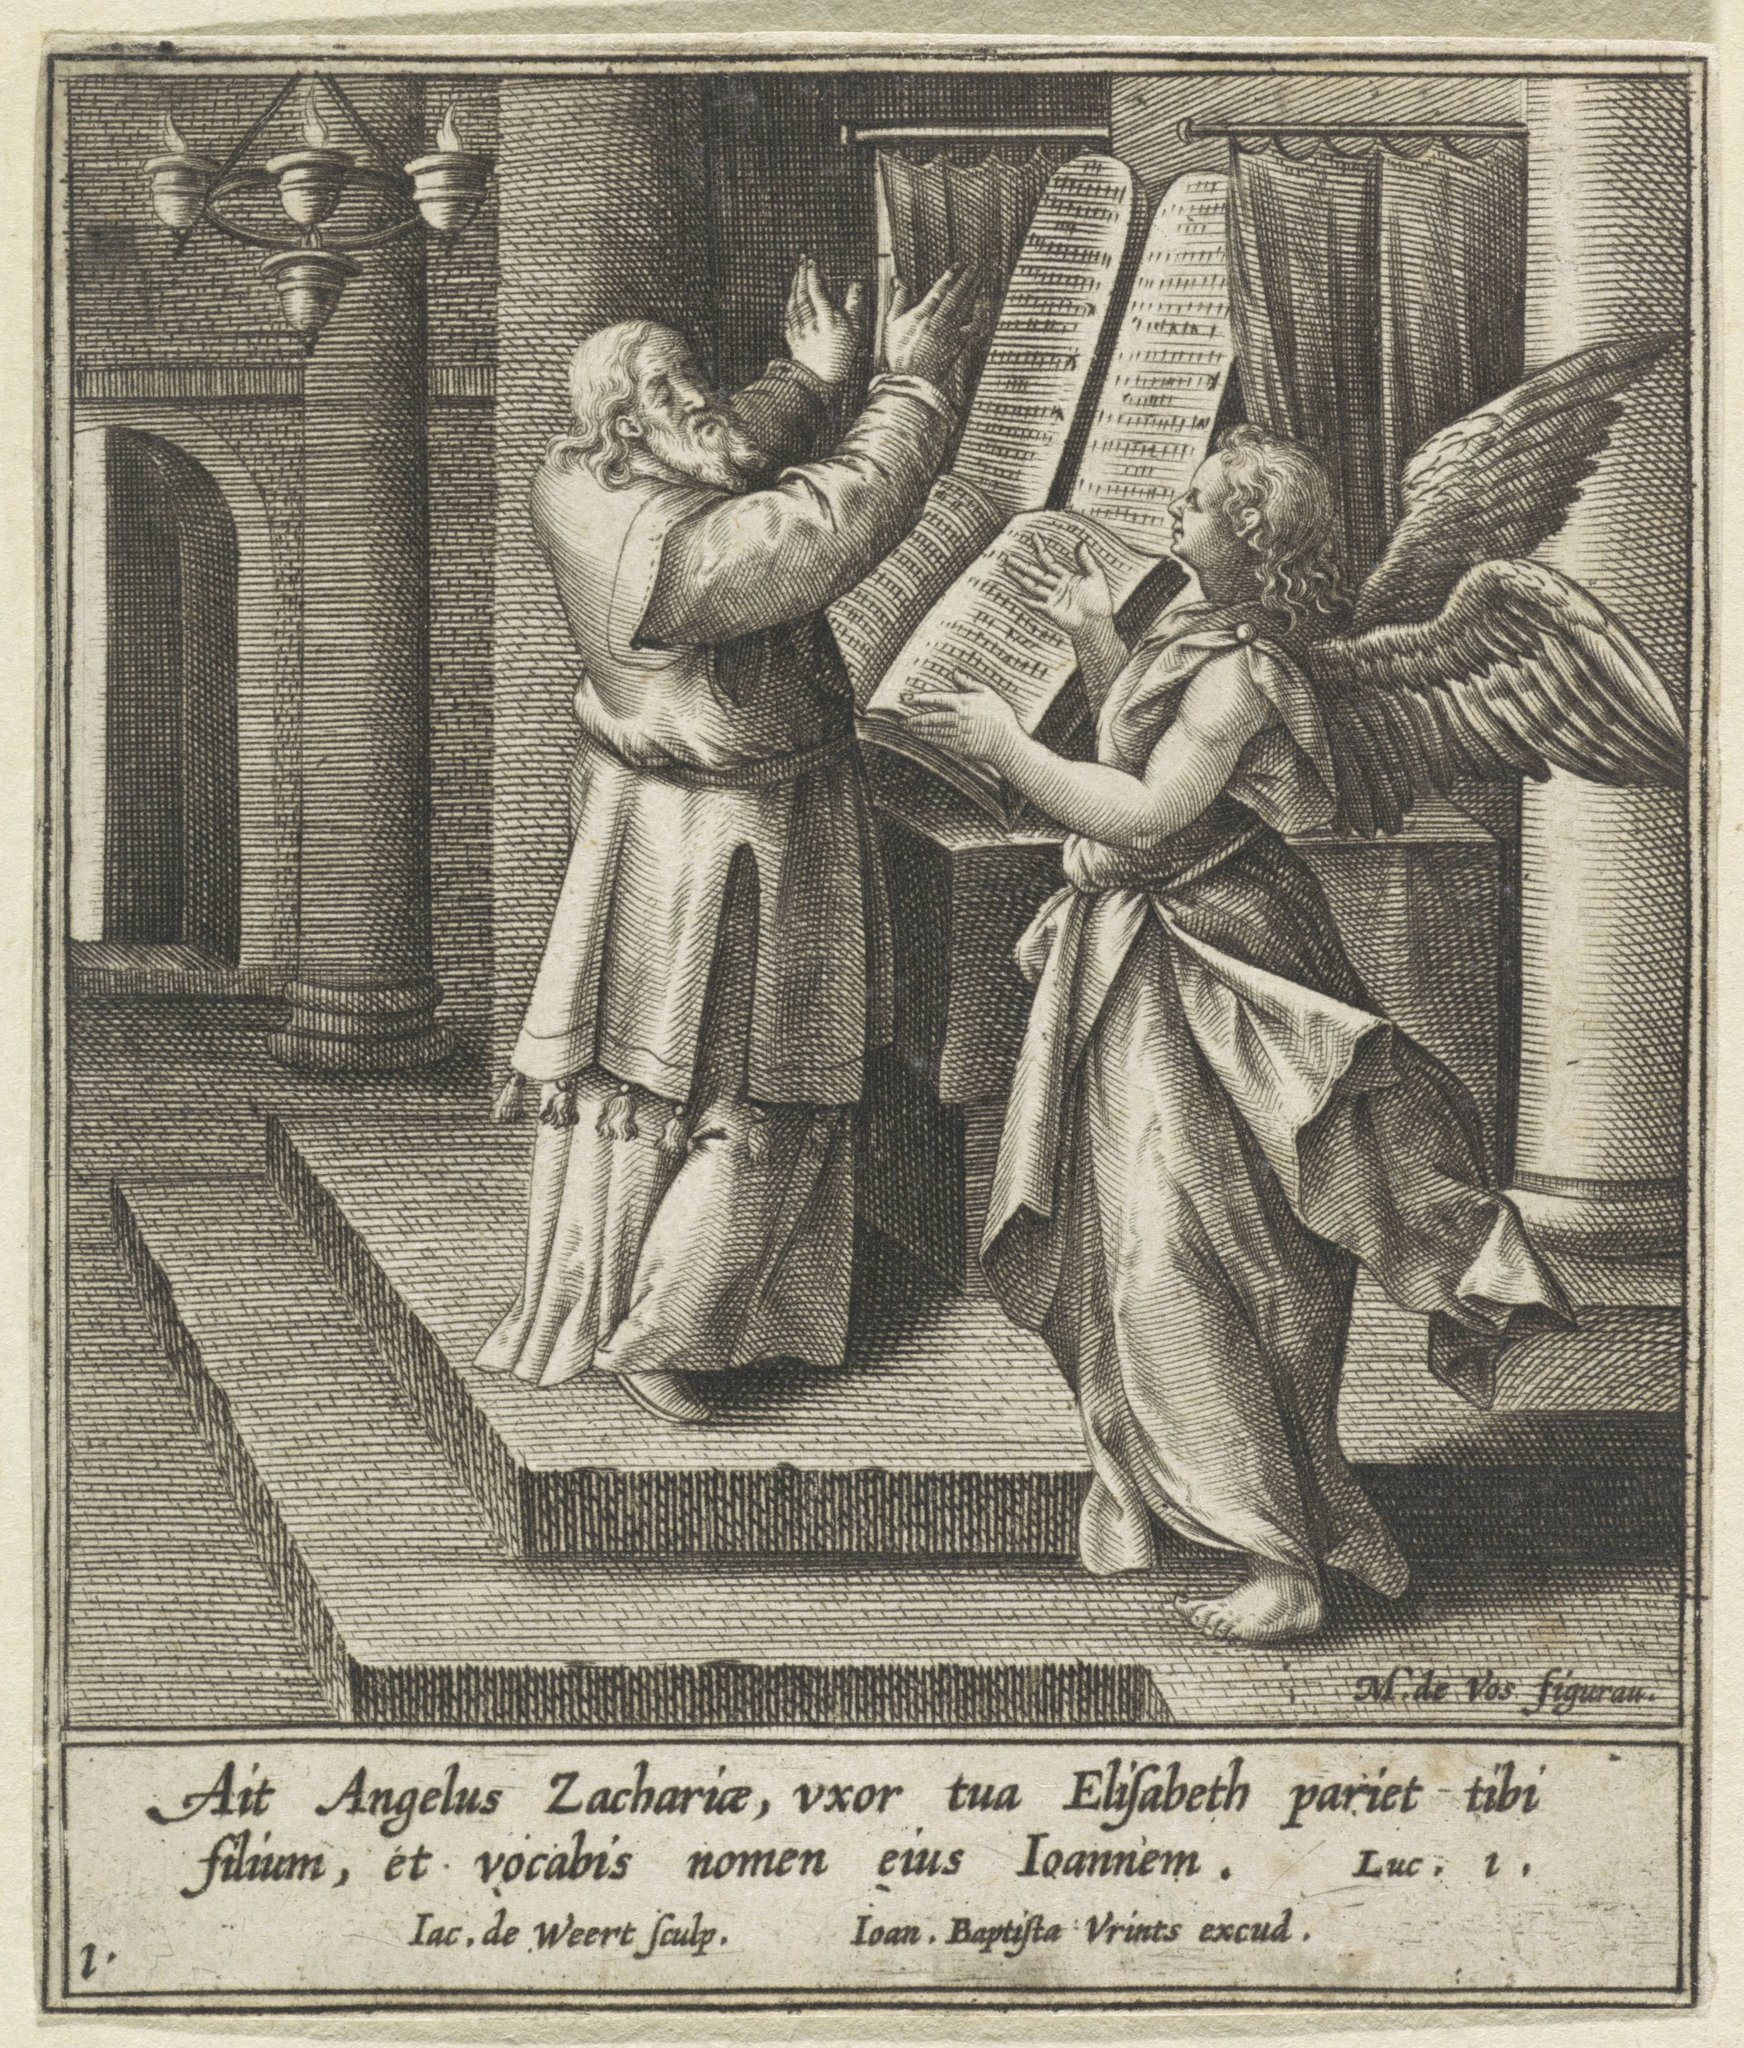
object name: print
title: Aankondiging aan Zacharias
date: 1580-1600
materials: paper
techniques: engraving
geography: antwerp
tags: annunciation of the birth of john the baptist to zacharias: while he is offering incense in the temple an angel (gabriel) appears to him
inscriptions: collector's mark: Lugt 240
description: Gabriël verschijnt aan de priester Zacharias in de tempel en kondigt de geboorte van Johannes de Doper aan. Zacharias staat bij een altaar met een opengeslagen boek en twee stenen tafelen. Onder de voorstelling bevindt zich een tweeregelige, Latijnse tekst uit Luc. 1 met een beschrijving van de scène.